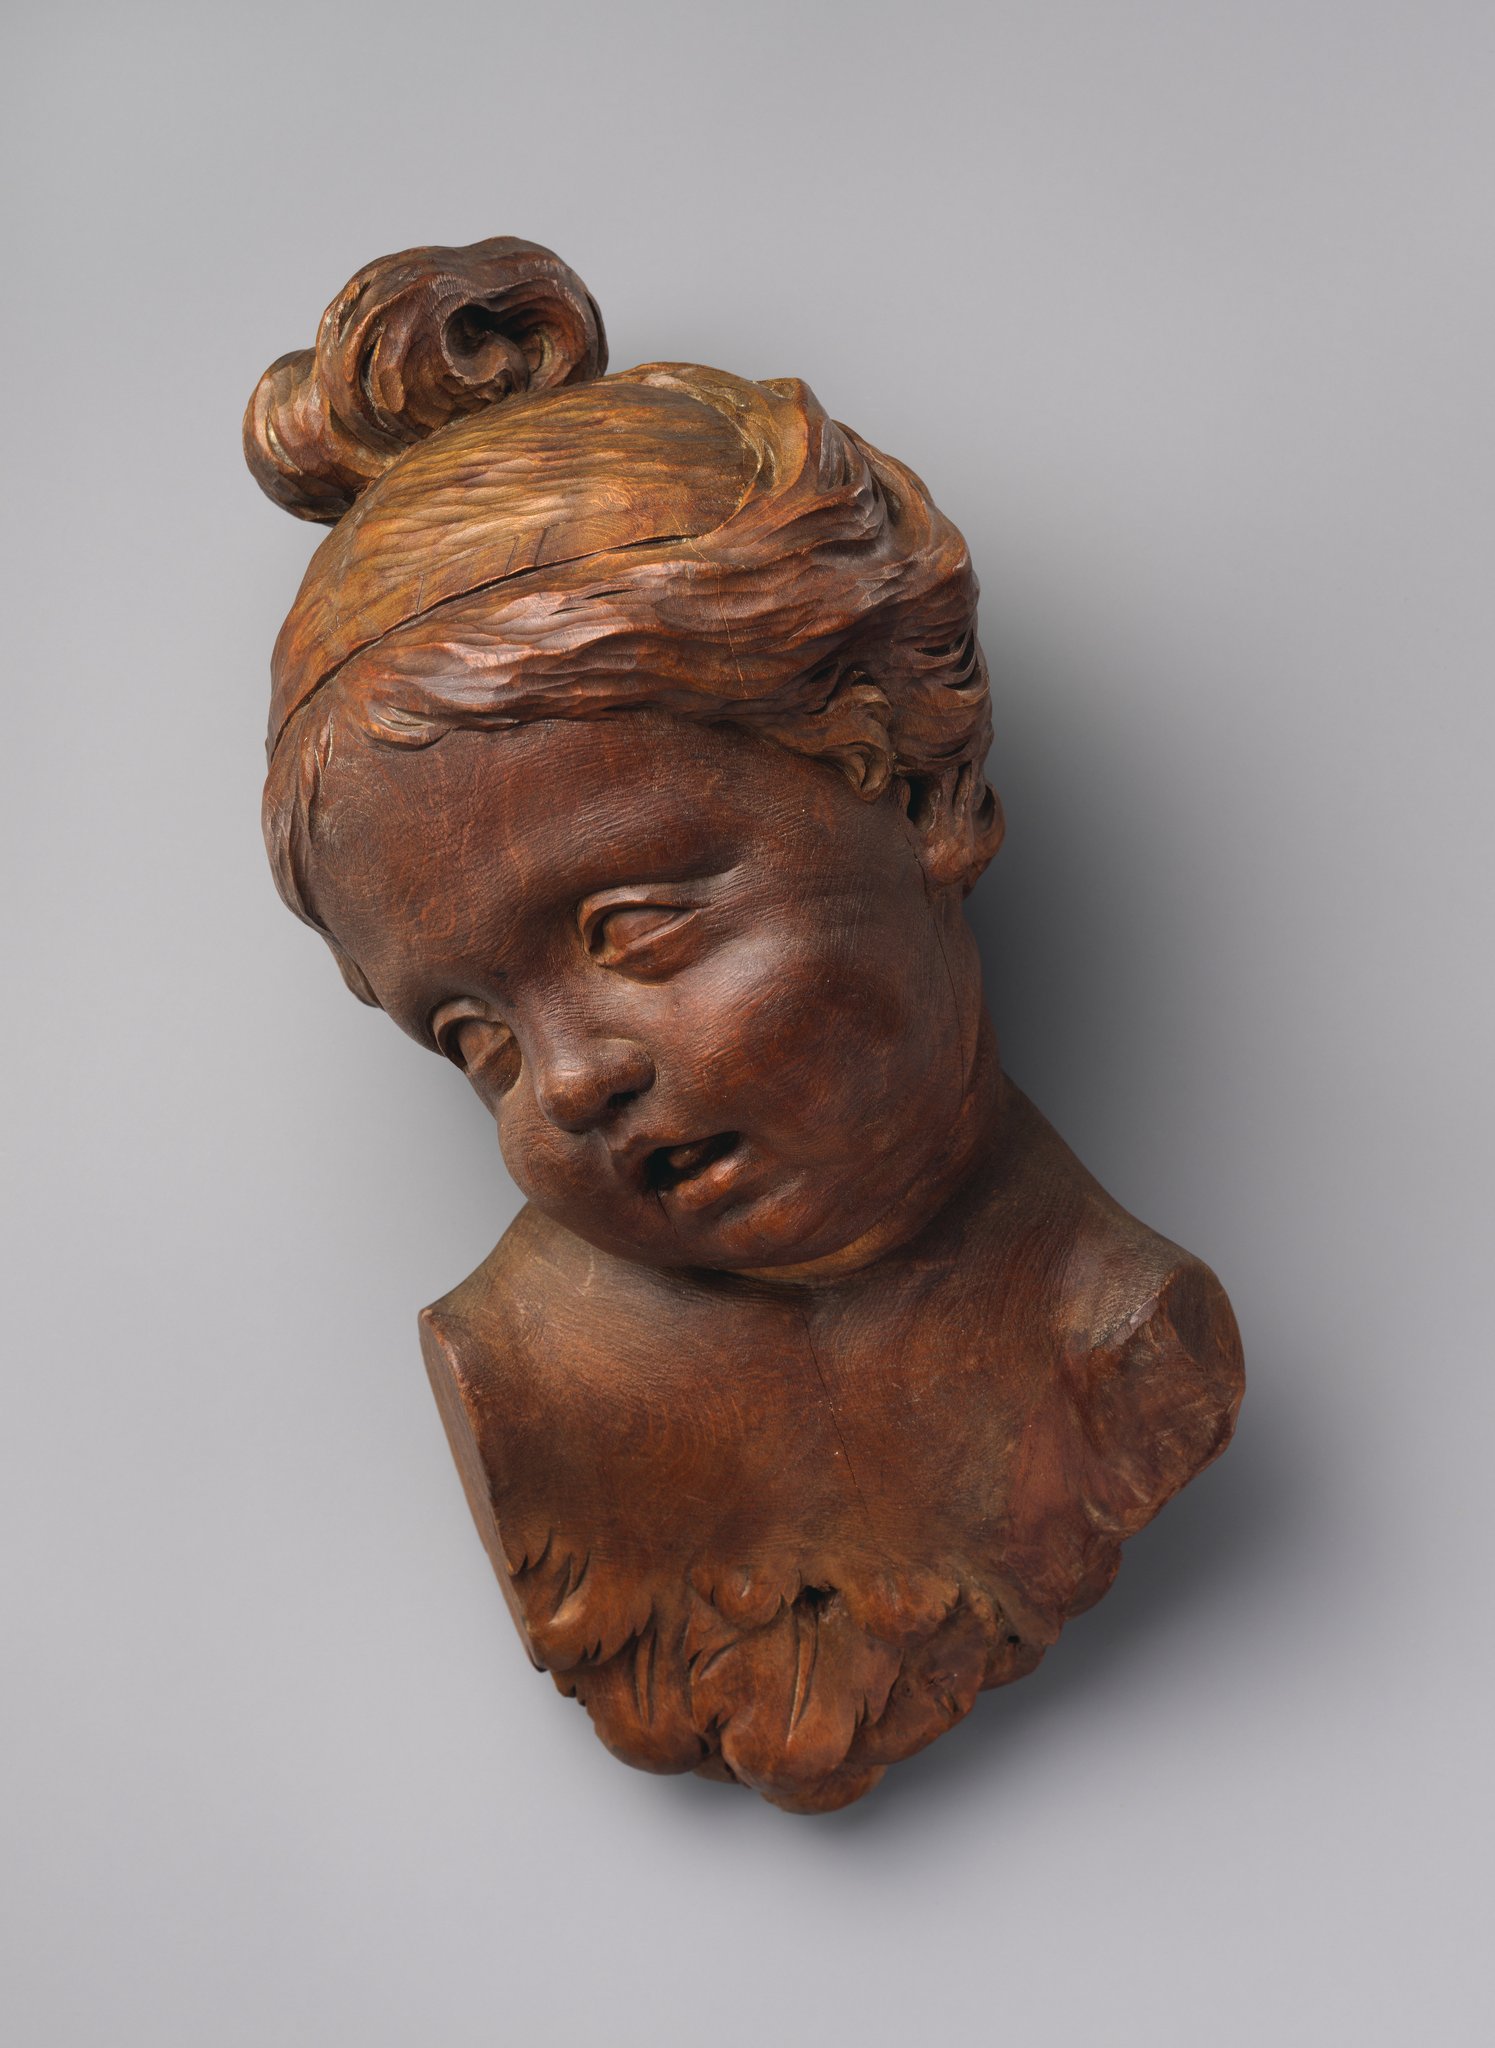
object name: head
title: Angel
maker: ignaz günther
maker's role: artist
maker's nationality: german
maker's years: 1725-1775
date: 1760-1770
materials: gesso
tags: angels